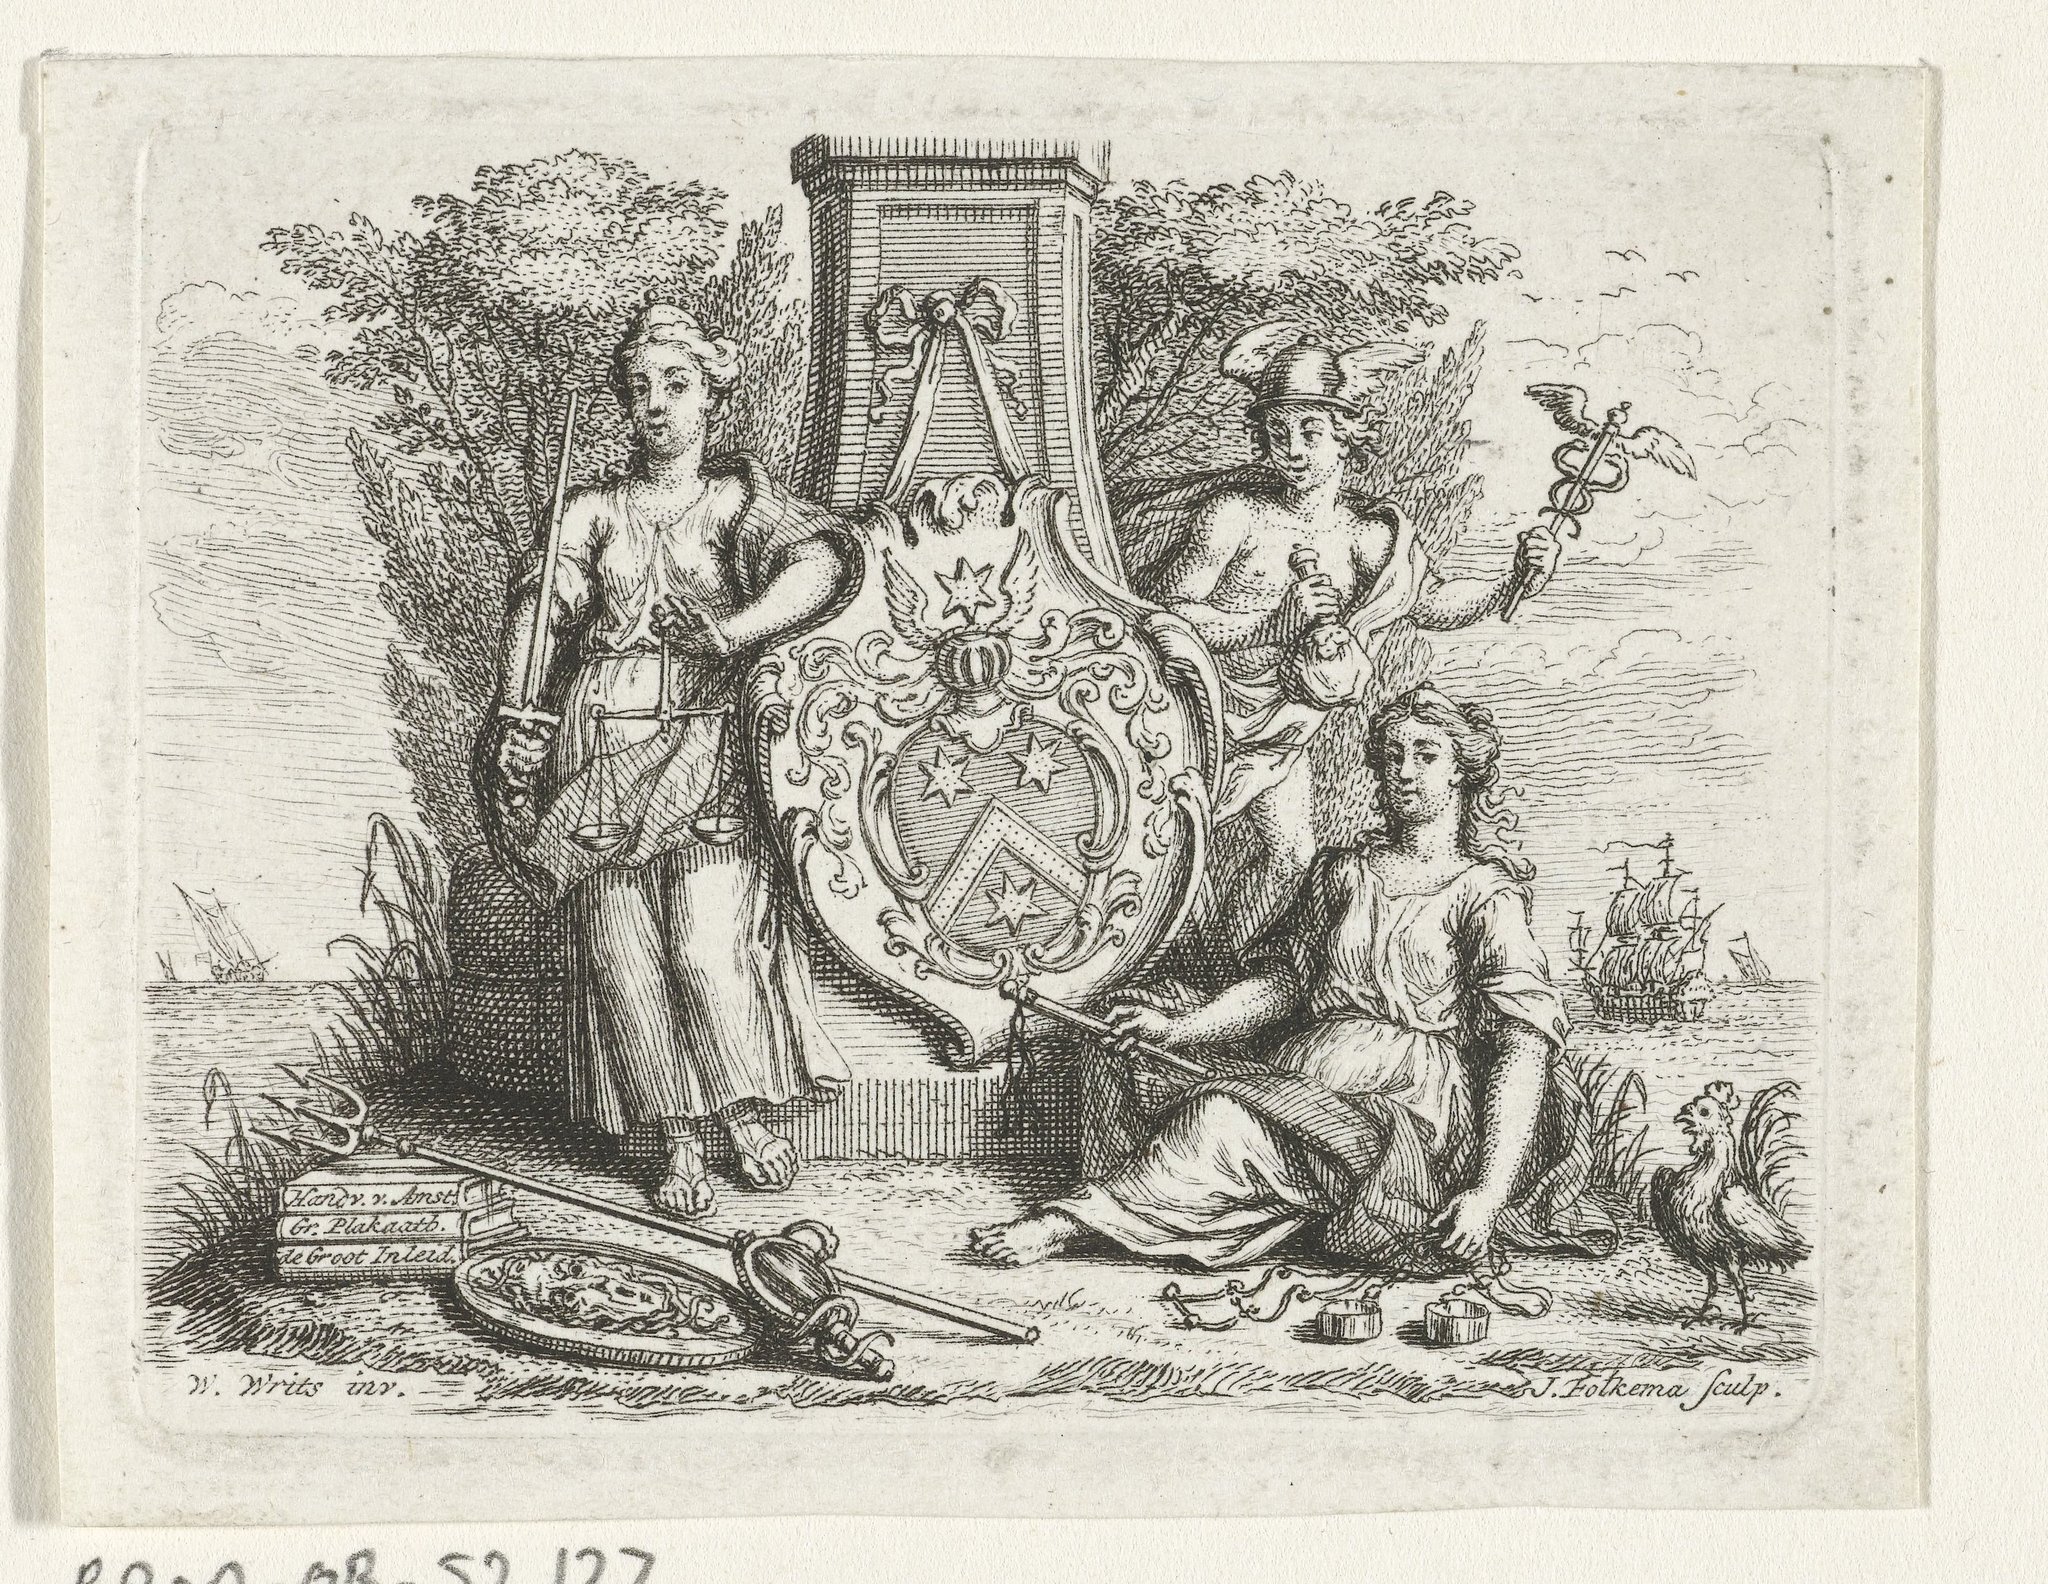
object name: print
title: Rechtvaardigheid, Matigheid en Mercurius bij een gedenkzuil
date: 1741-1767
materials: paper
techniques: etching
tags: temperance, 'temperantia'; 'temperanza' (ripa) ~ one of the four cardinal virtues, justice, 'justitia'; 'giustitia divina' (ripa) ~ one of the four cardinal virtues, (story of) mercury (hermes), other memorial structures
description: De kardinale deugden Rechtvaardigheid en Matigheid staan met Mercurius rond een gedenkzuil waar met een lint een wapenschild is opgehangen.